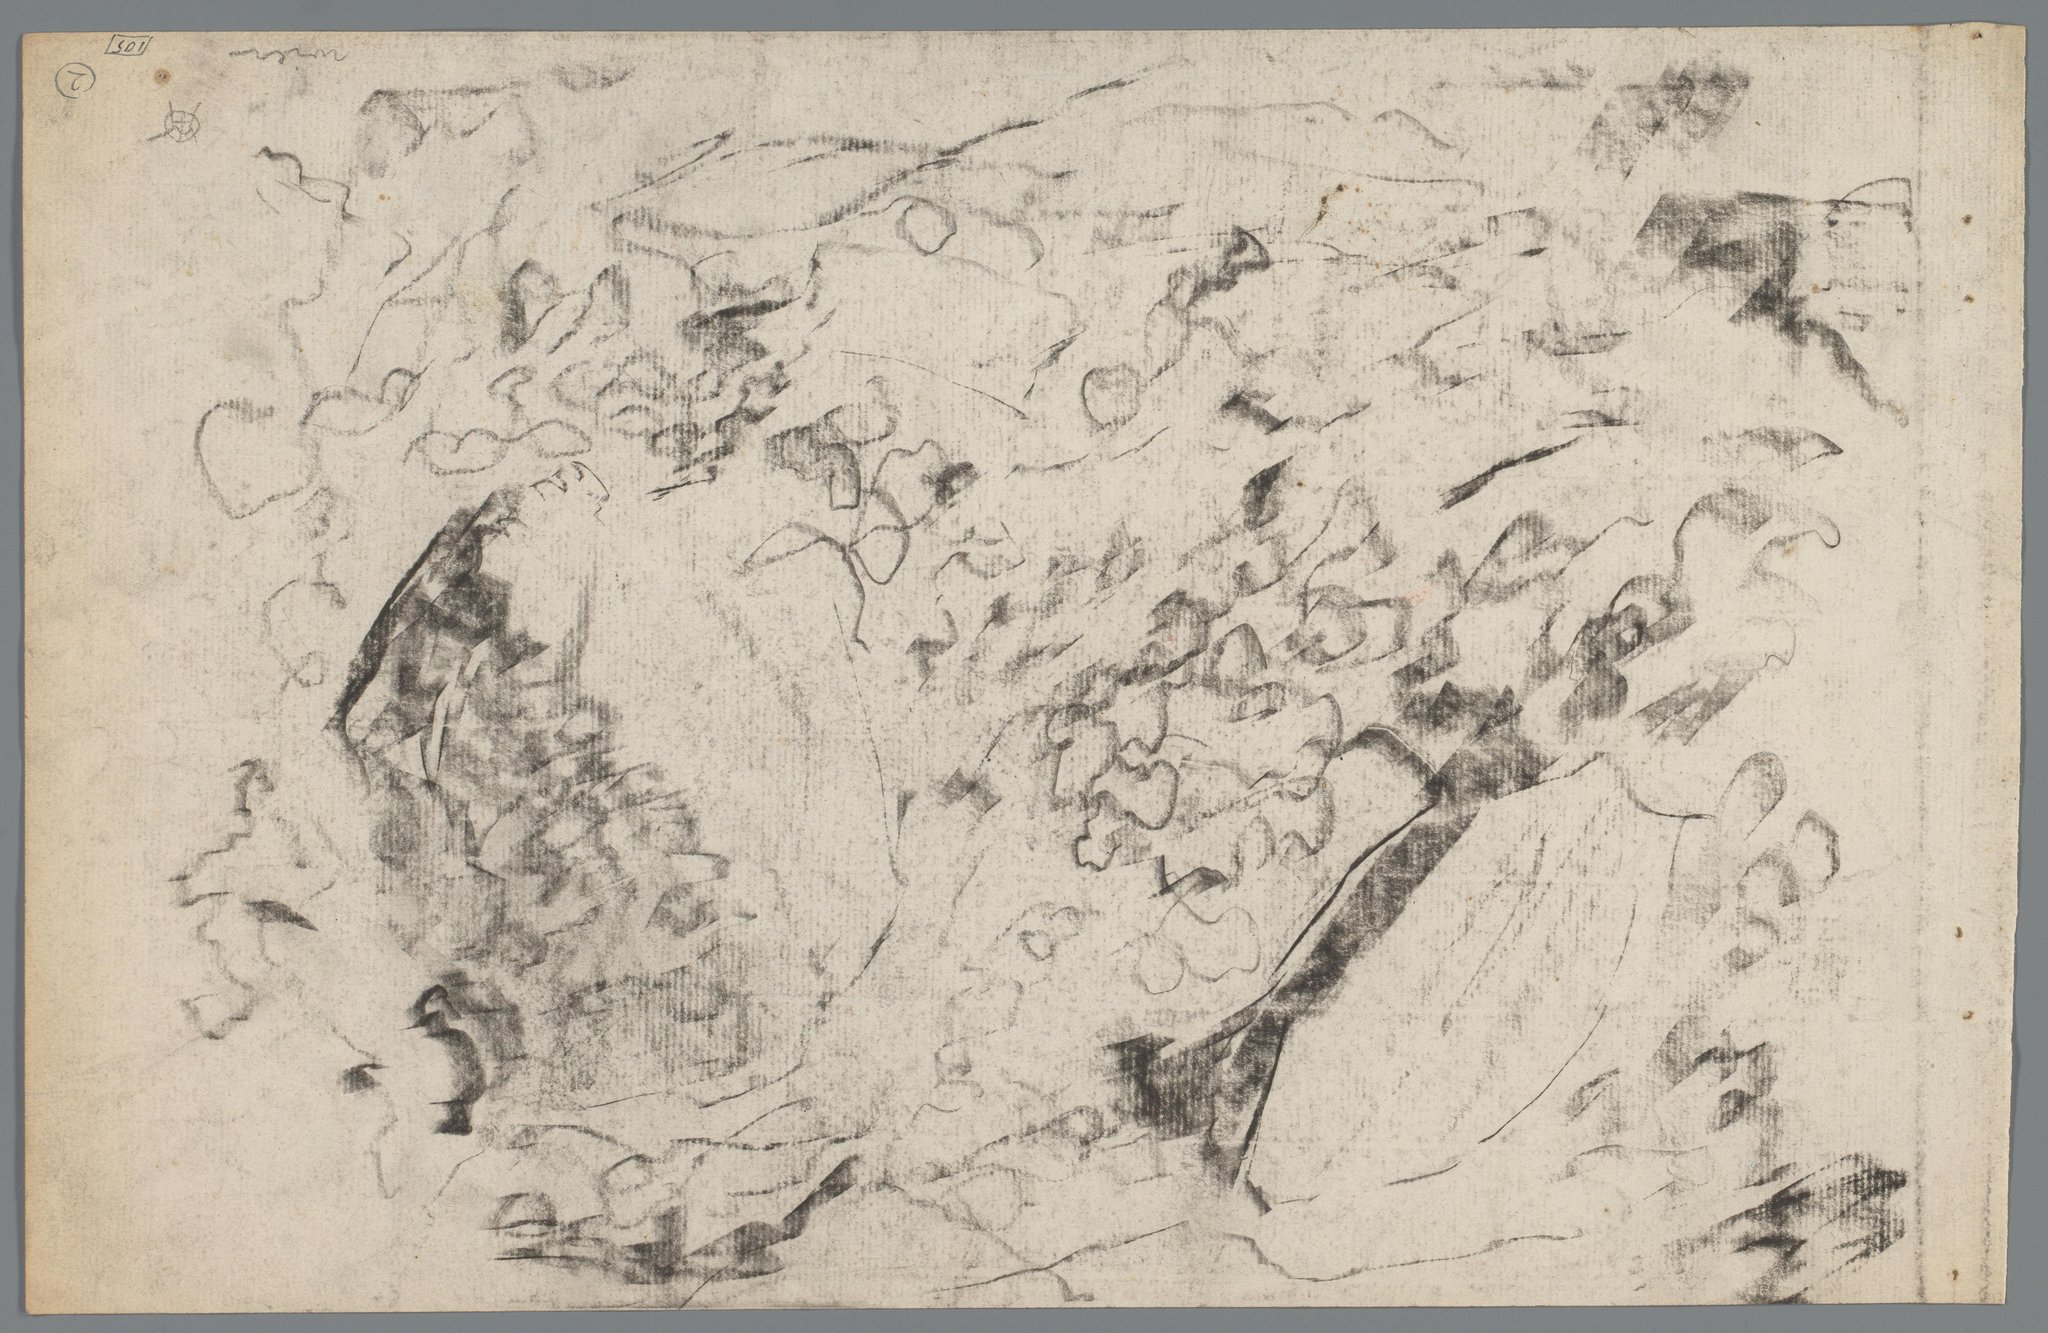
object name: drawing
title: Studie van een aquarium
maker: gerrit willem dijsselhof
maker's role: designer, draughtsman, print maker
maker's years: 1866-1924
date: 1876-1924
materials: chalk, paper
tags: aquarium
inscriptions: number: ‘2’, number: ‘105’